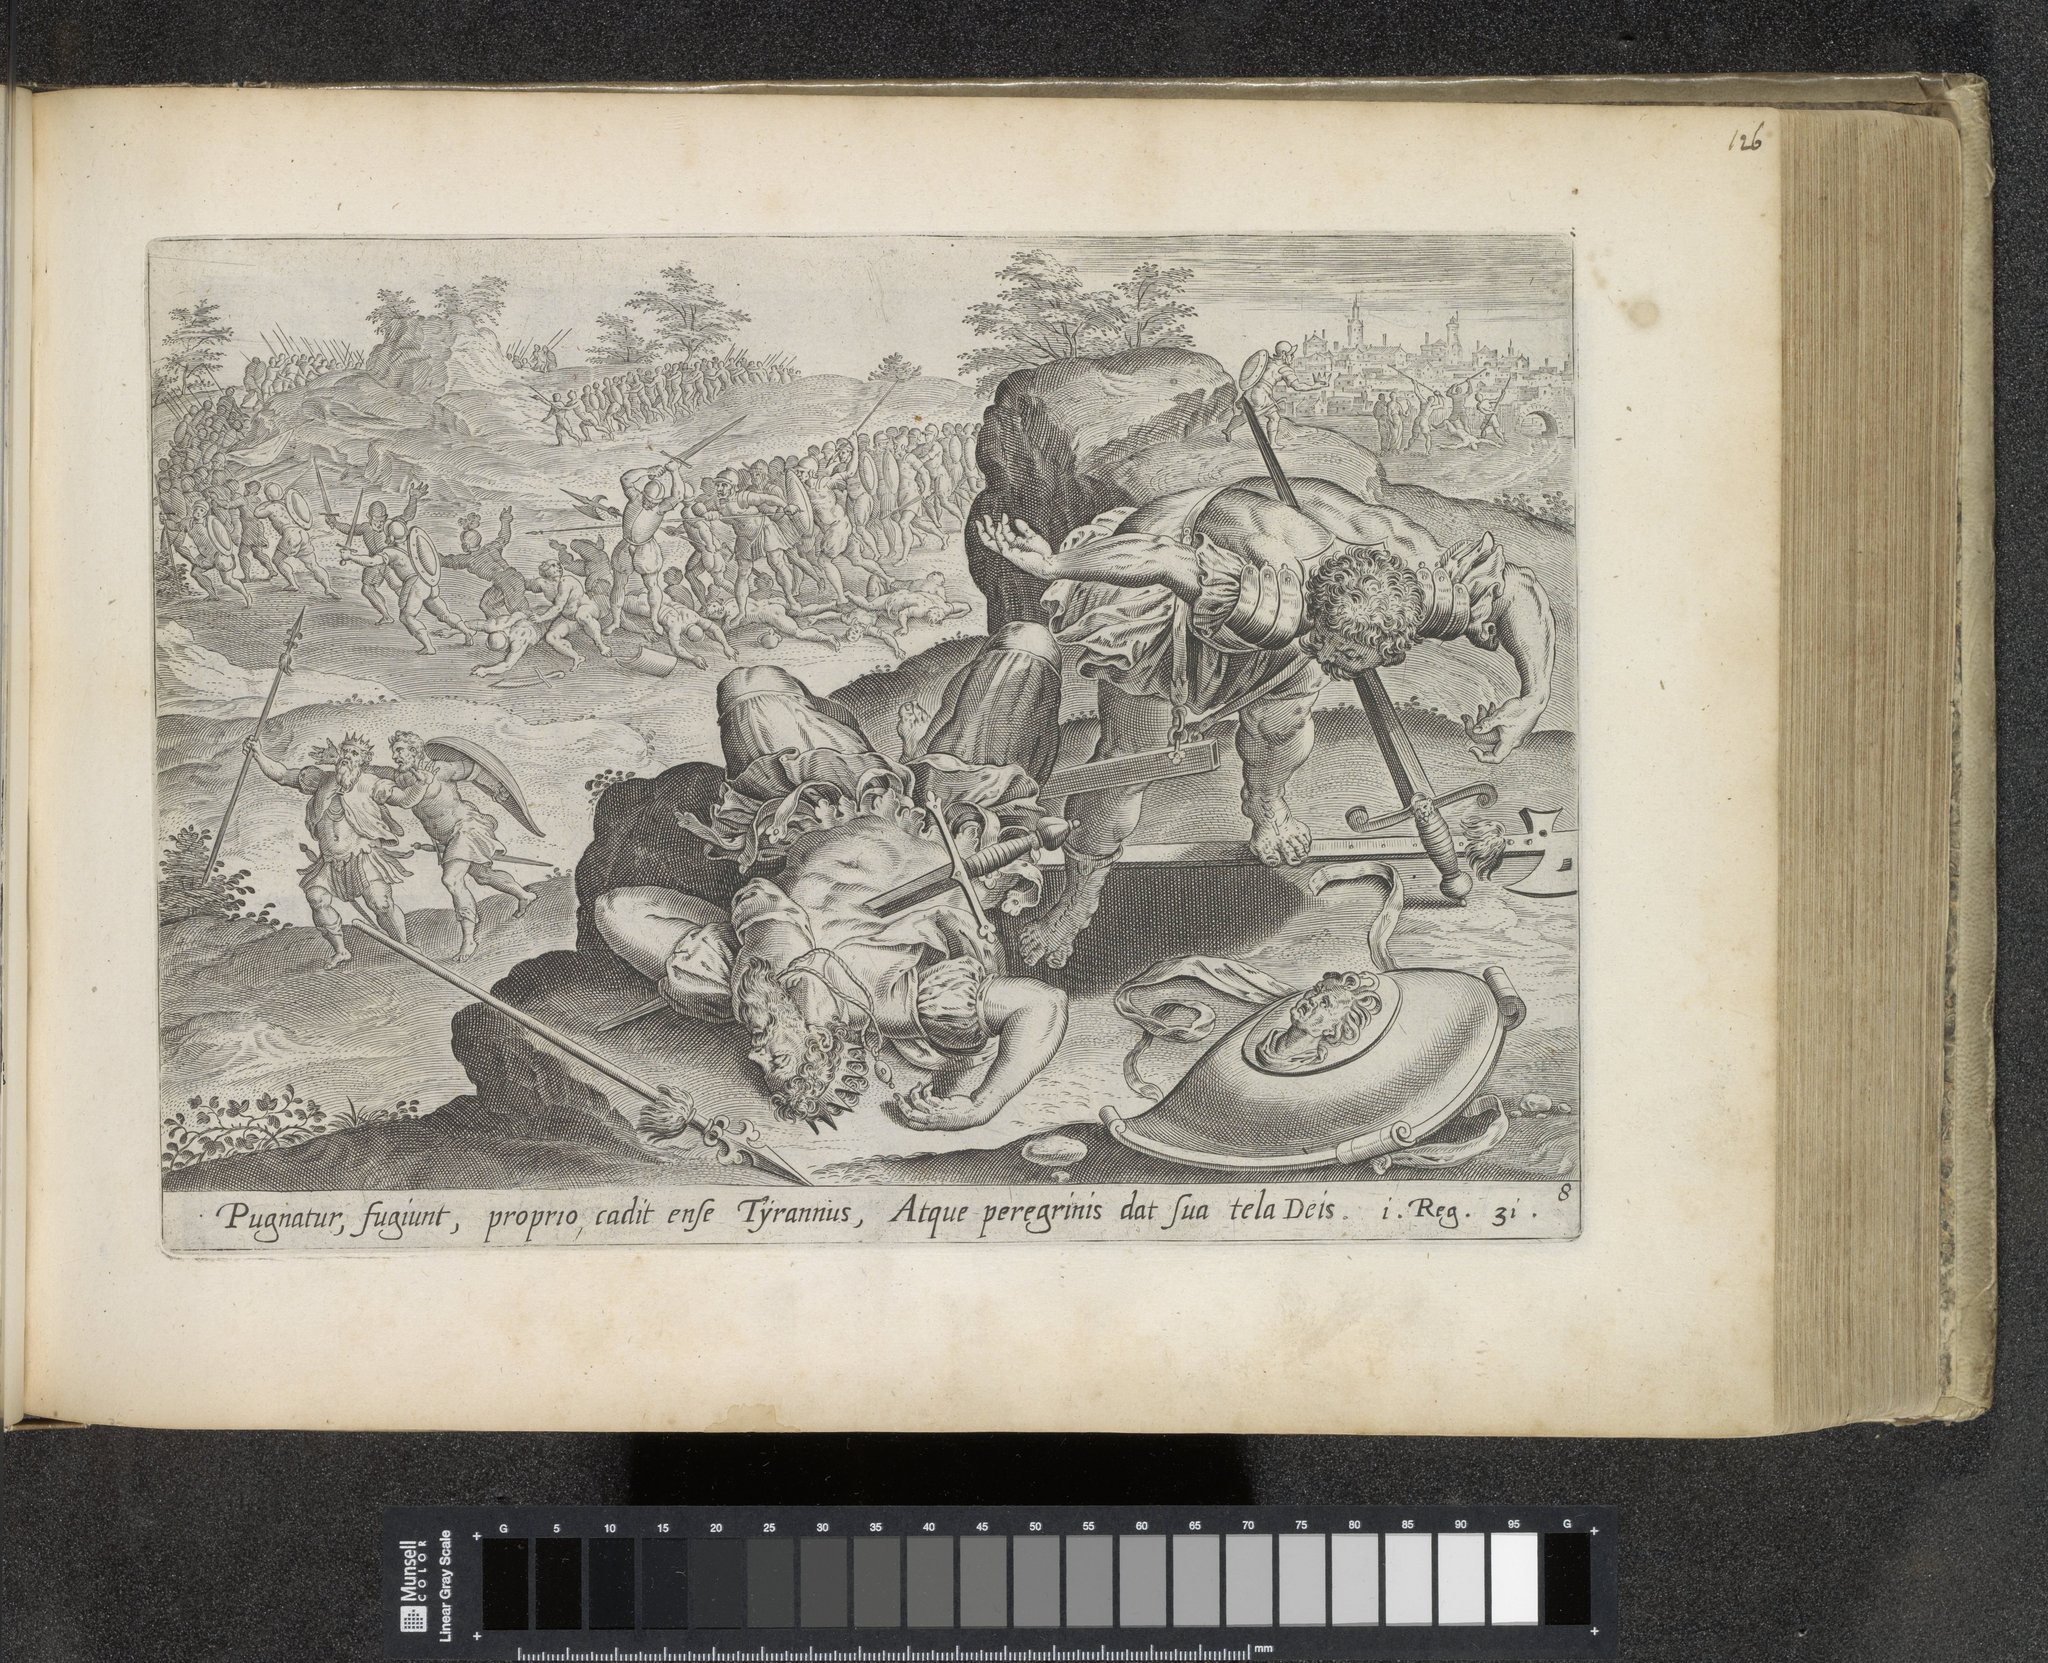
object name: album leaf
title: Geschiedenis van David en Saul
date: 1579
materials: paper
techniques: engraving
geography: amsterdam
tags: saul's armour-bearer kills himself, saul kills himself with a sword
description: Op de achtergrond vluchten Saul en zijn wapendrager weg van het Filistijnse leger. Op de voorgrond hebben beiden zelfmoord gepleegd door zich in hun zwaarden te storten. Onder de voorstelling een verwijzing in het Latijn naar de Bijbeltekst in 1 Sam. 31. Deze prent maakt deel uit van een album.